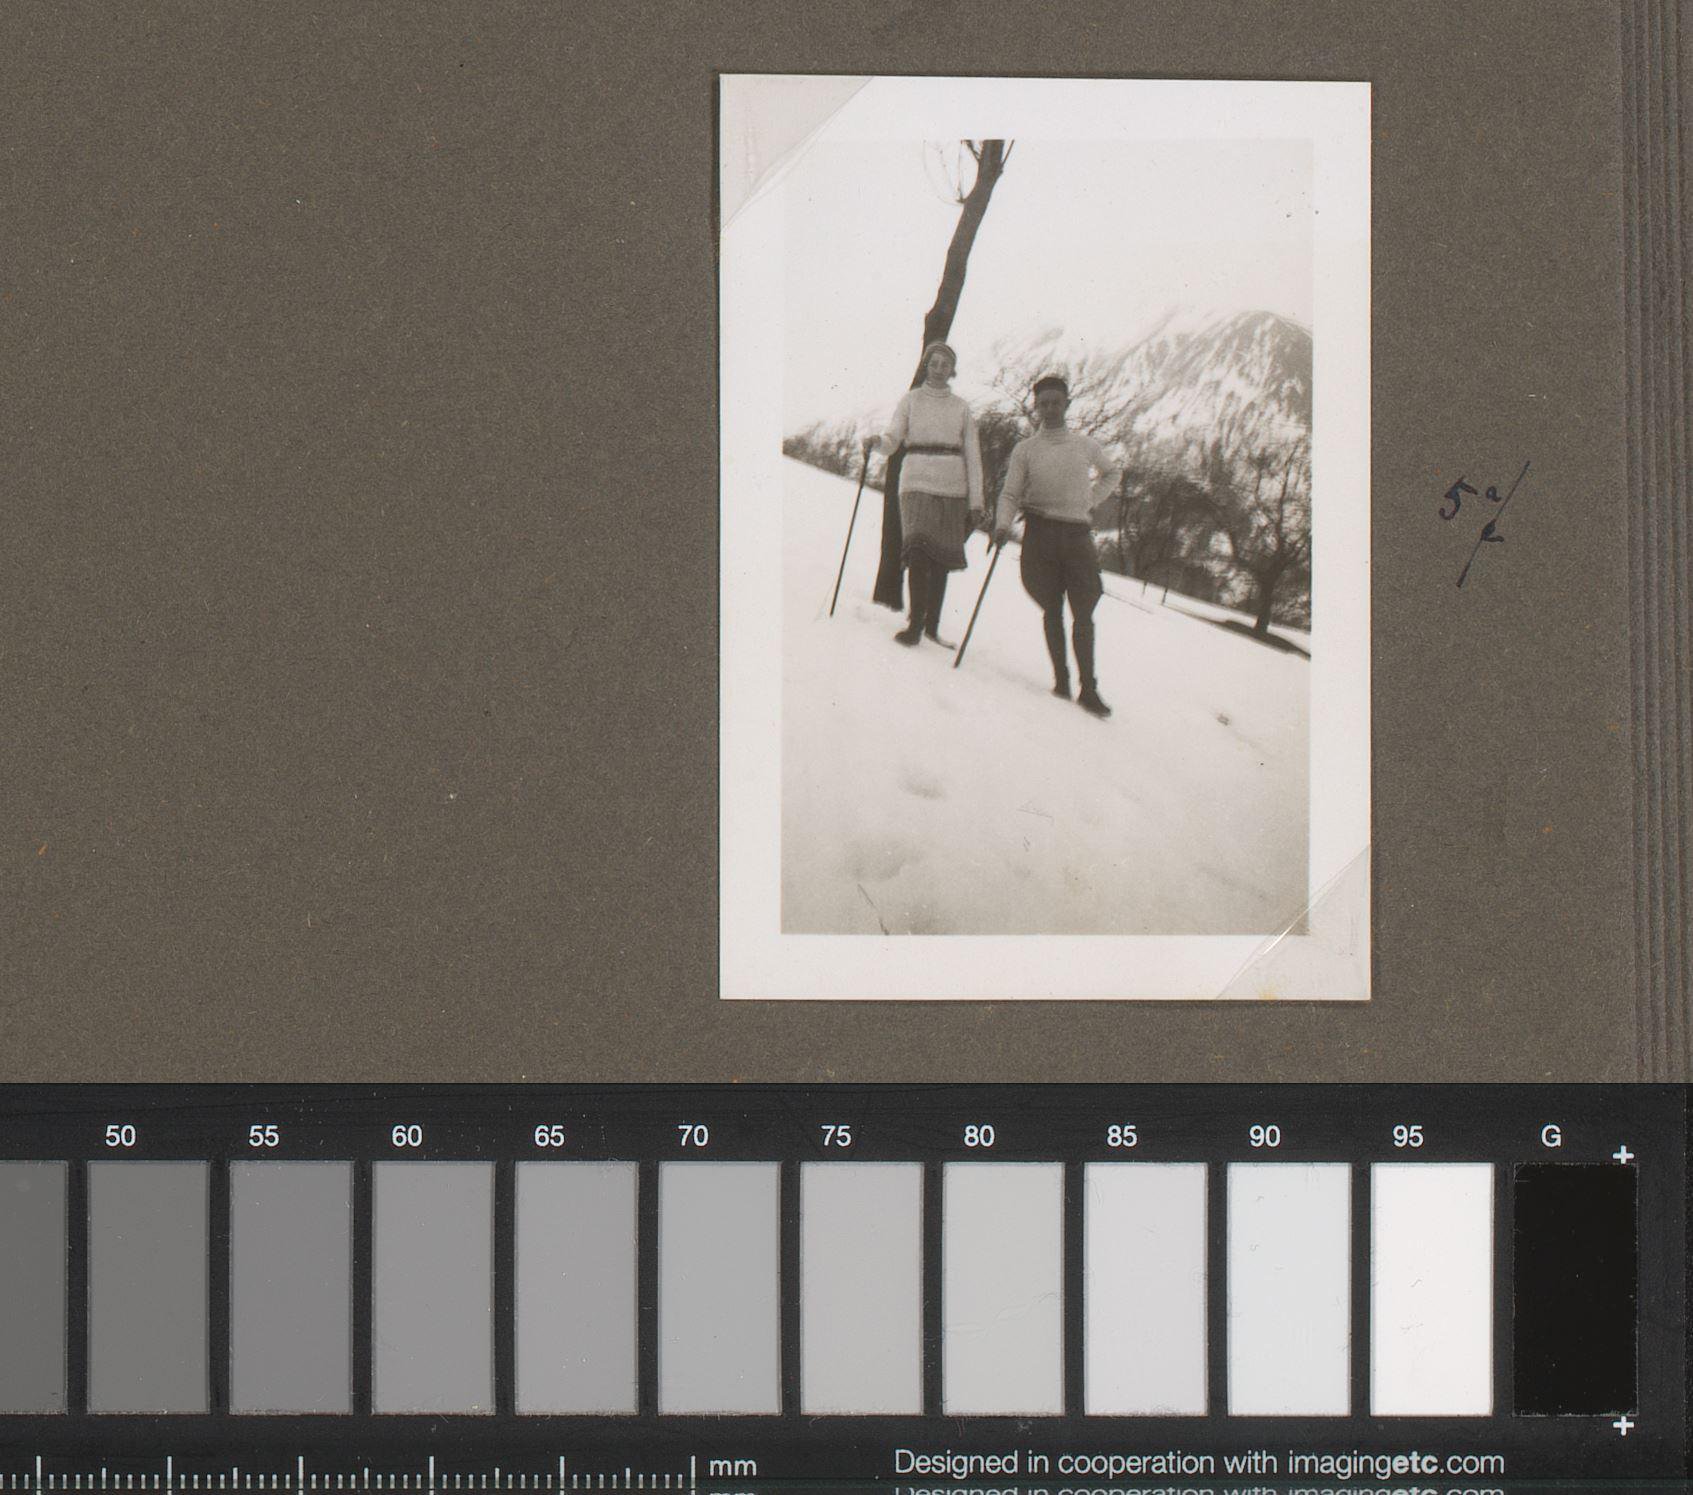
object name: album leaf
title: De Condra op. Sietske Streekstra en Dr. E. v. Steenis in de sneeuw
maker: Anonymous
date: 1934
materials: photographic support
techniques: gelatin silver print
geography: capriasca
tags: adult woman, adult man, snow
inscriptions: number: ‘57’